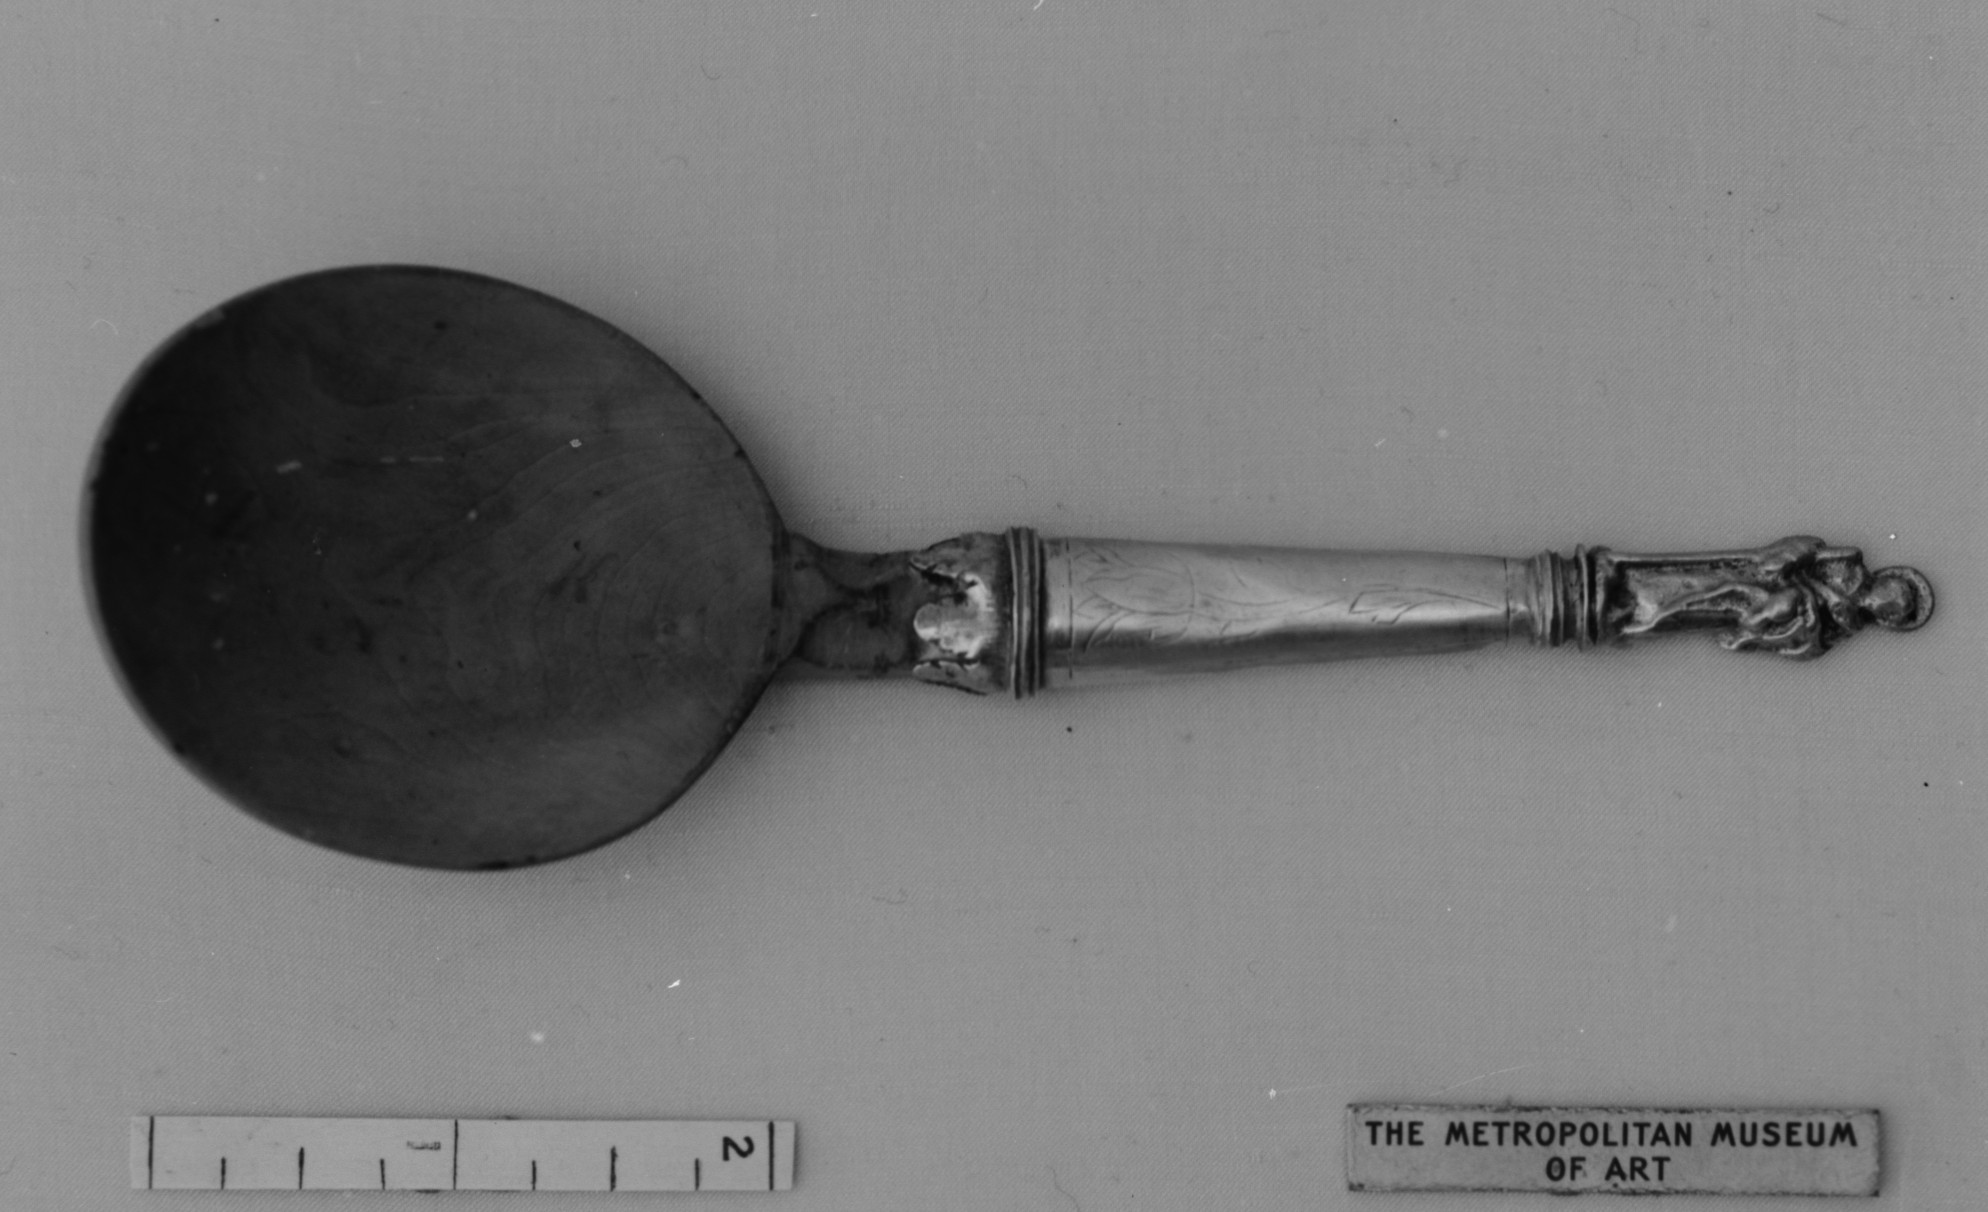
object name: apostle spoon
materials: silver, wood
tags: apostles